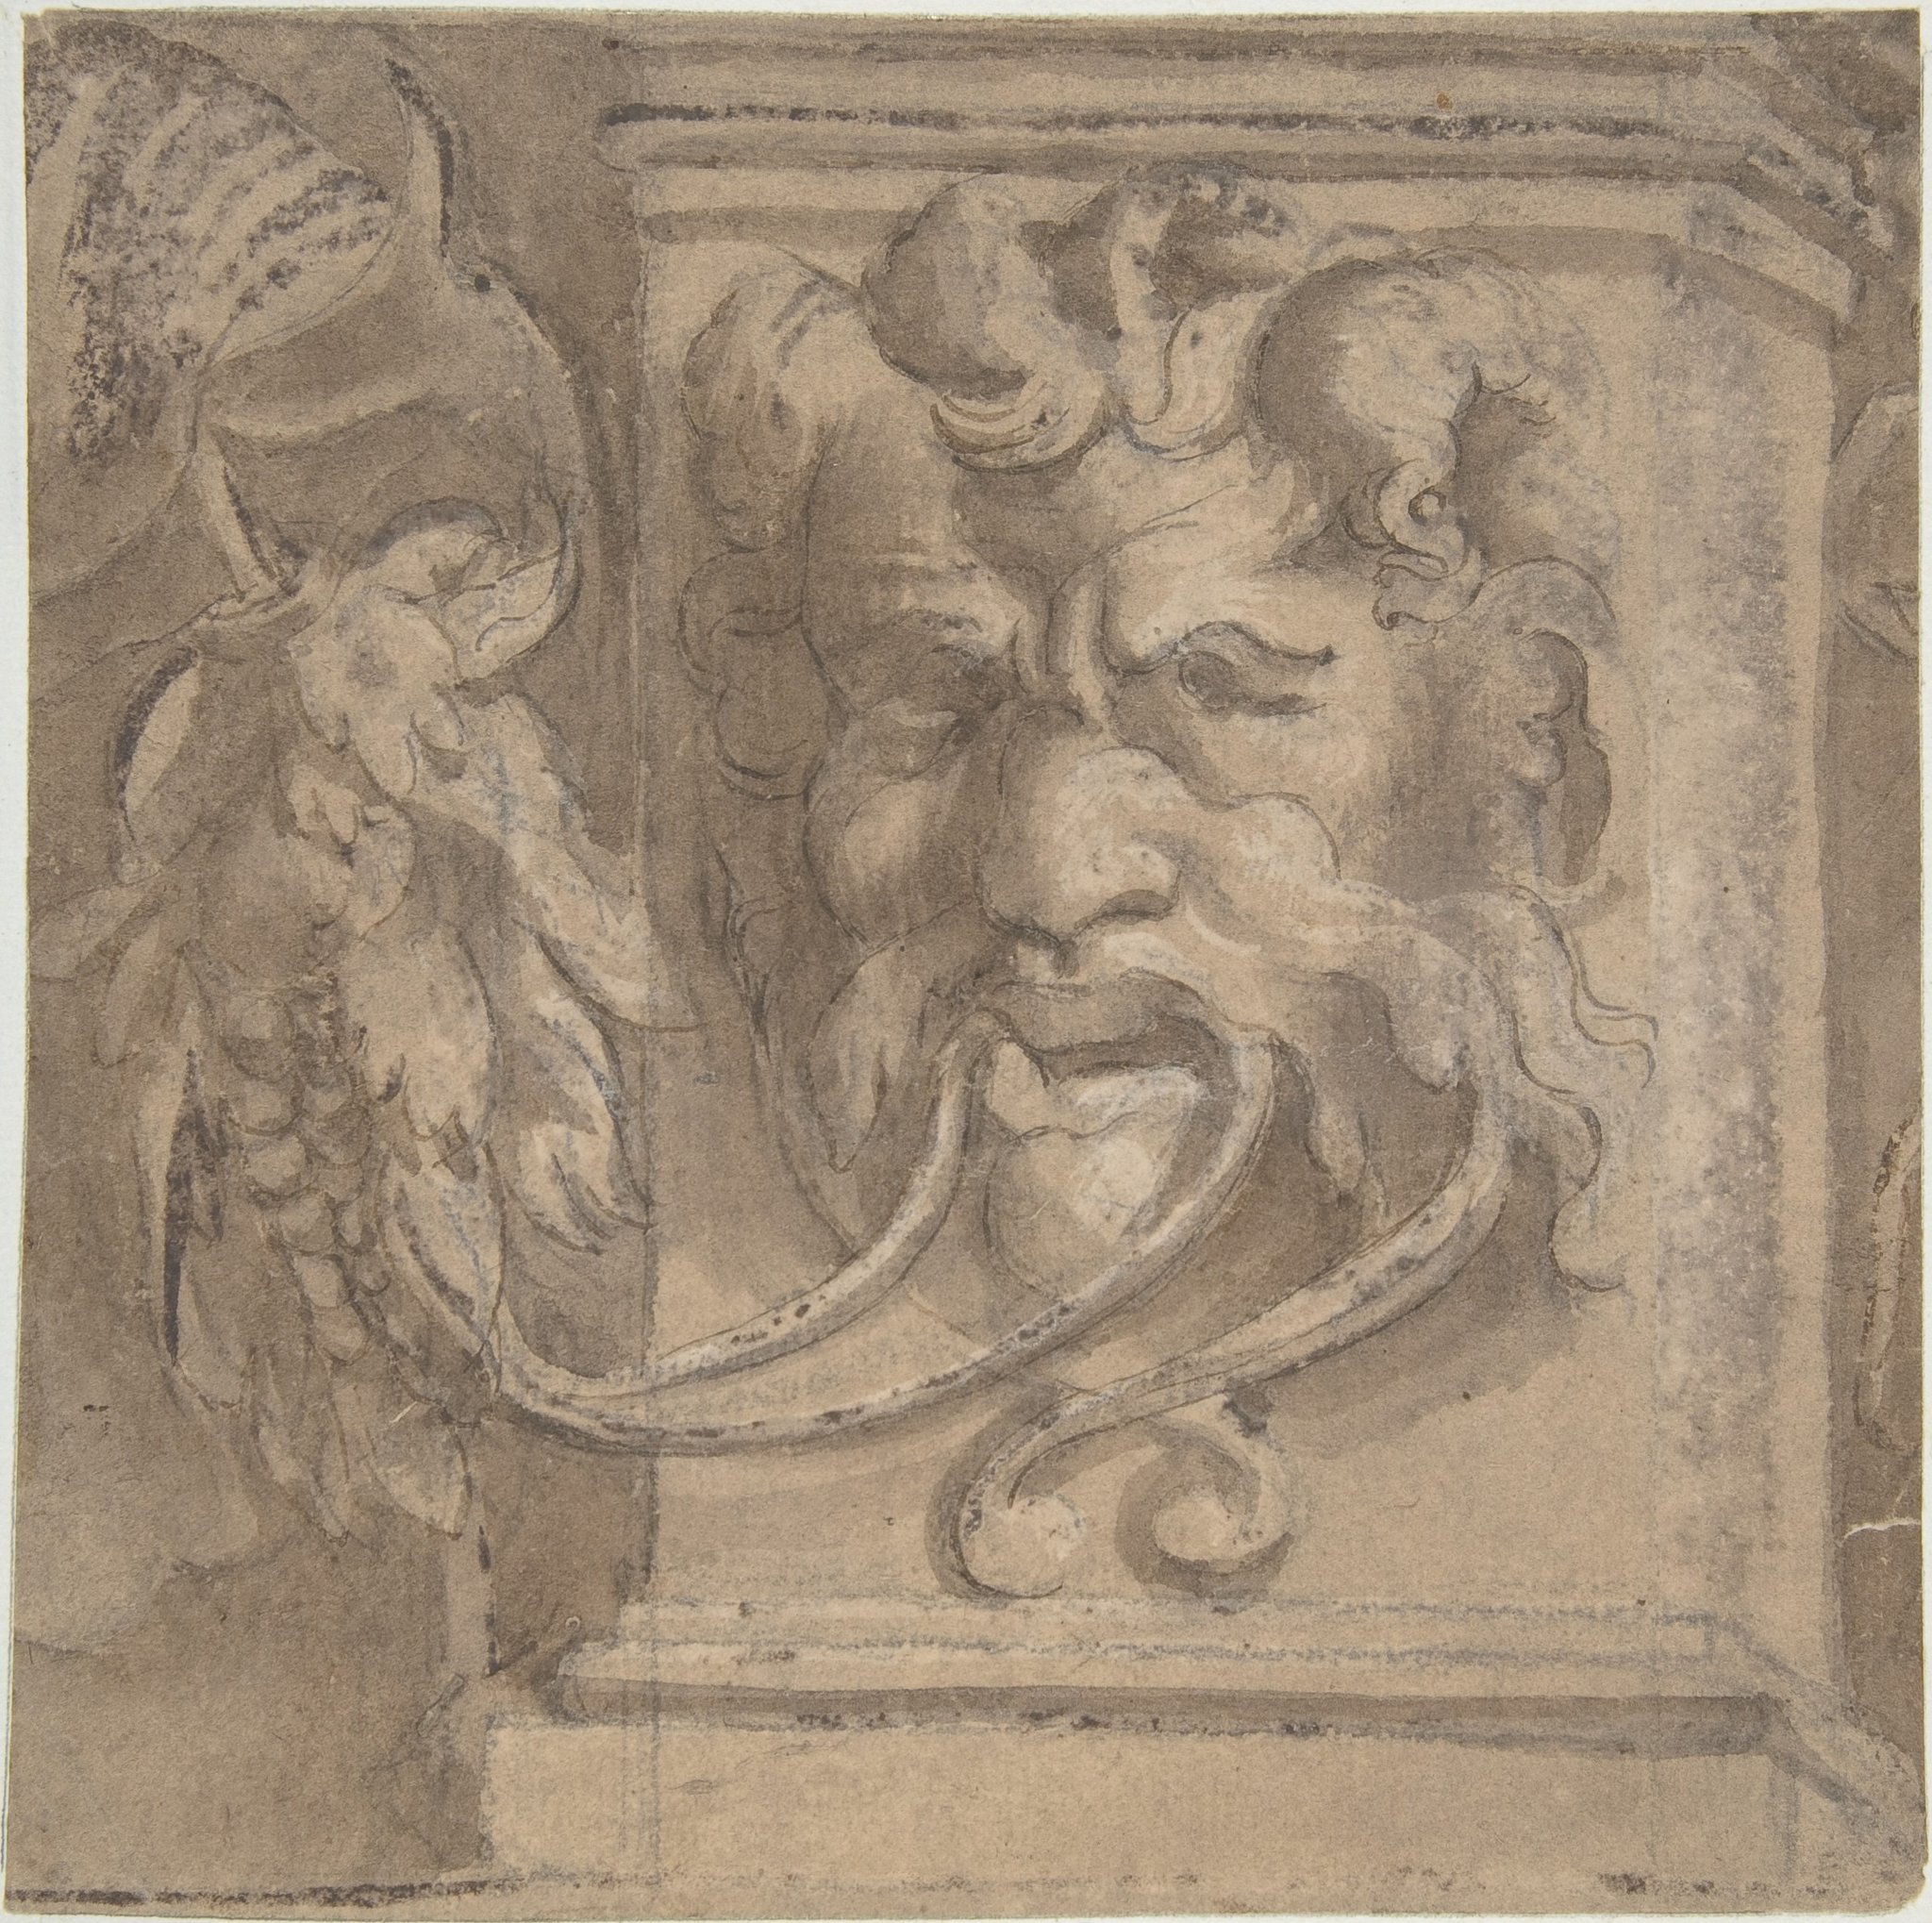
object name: ornament architecture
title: Ornamental Design with Antique-style Mask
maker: anonymous, italian, 16th century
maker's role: artist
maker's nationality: italian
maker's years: 1500-1600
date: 1550-1600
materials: chalk, gouache, ink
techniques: brush, highlighting, pen, wash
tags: masks,ornament